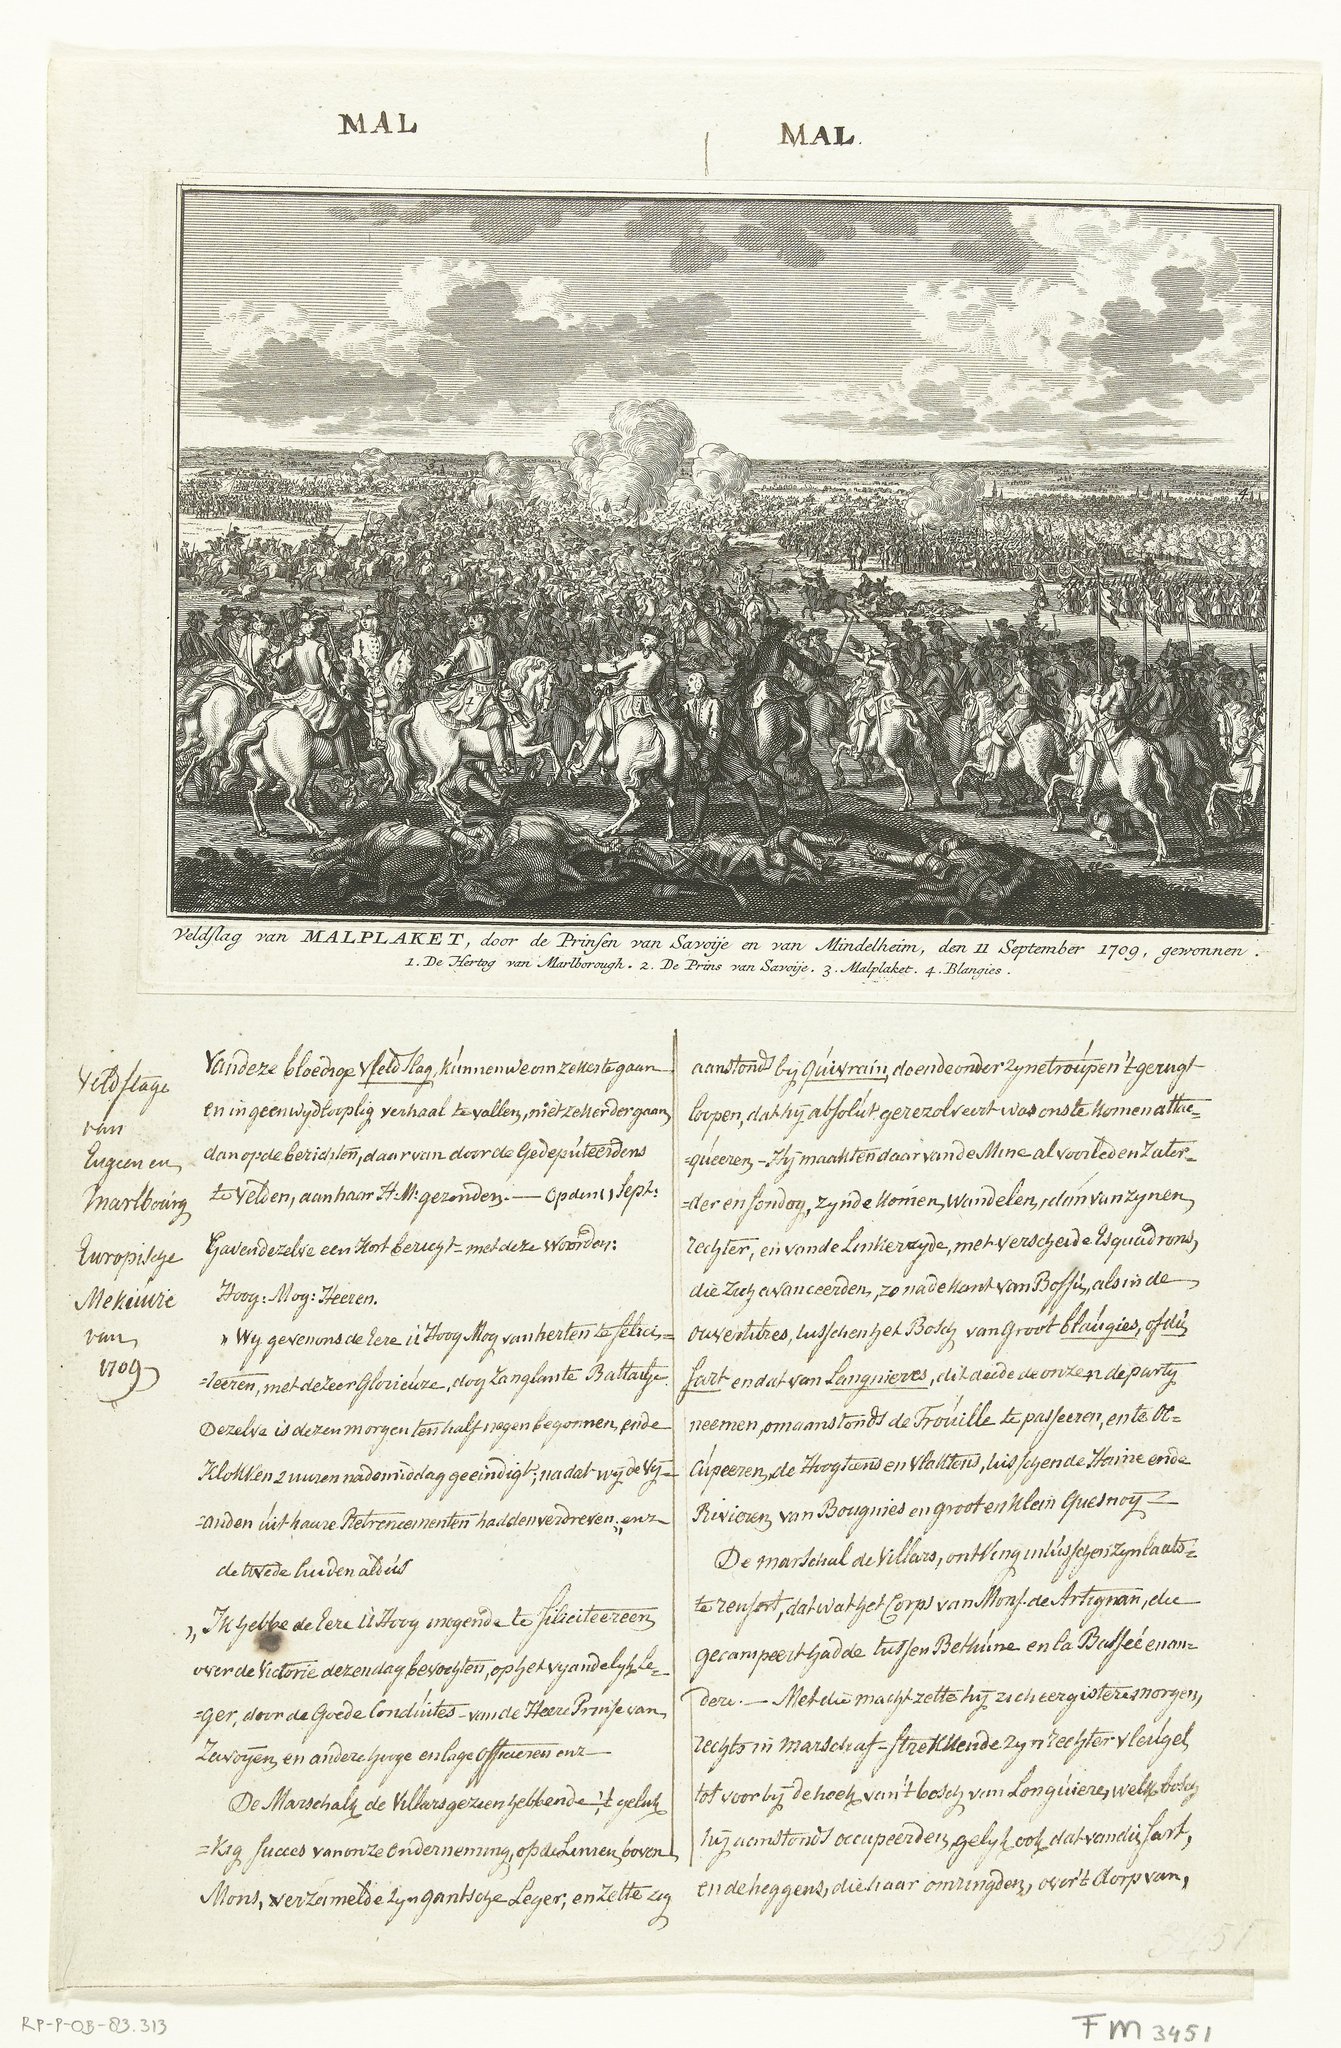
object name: print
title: Veldslag van Malplaket, door de Prinsen van Savoije en van Mindelheim, den 11 September 1709, gewonnen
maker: adolf van der laan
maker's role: draughtsman, print maker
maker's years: 1689-1742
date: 1709-1755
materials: paper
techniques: engraving, etching, writing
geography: northern netherlands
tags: vienna, eugenius van savoye, john churchill (1e hertog van marlborough), battle (+ land forces)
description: De slag bij Malplaquet tussen de Geallieerden onder de hertog van Marlborough en prins Eugenius van Savoye en de Fransen, 11 september 1709. De prent geplakt op een dubbelgevouwen blad met handschrift op twee zijden met een beschrijving van het verloop van de slag. De bladzijden zijn bovenaan gemerkt met pen: MAL.